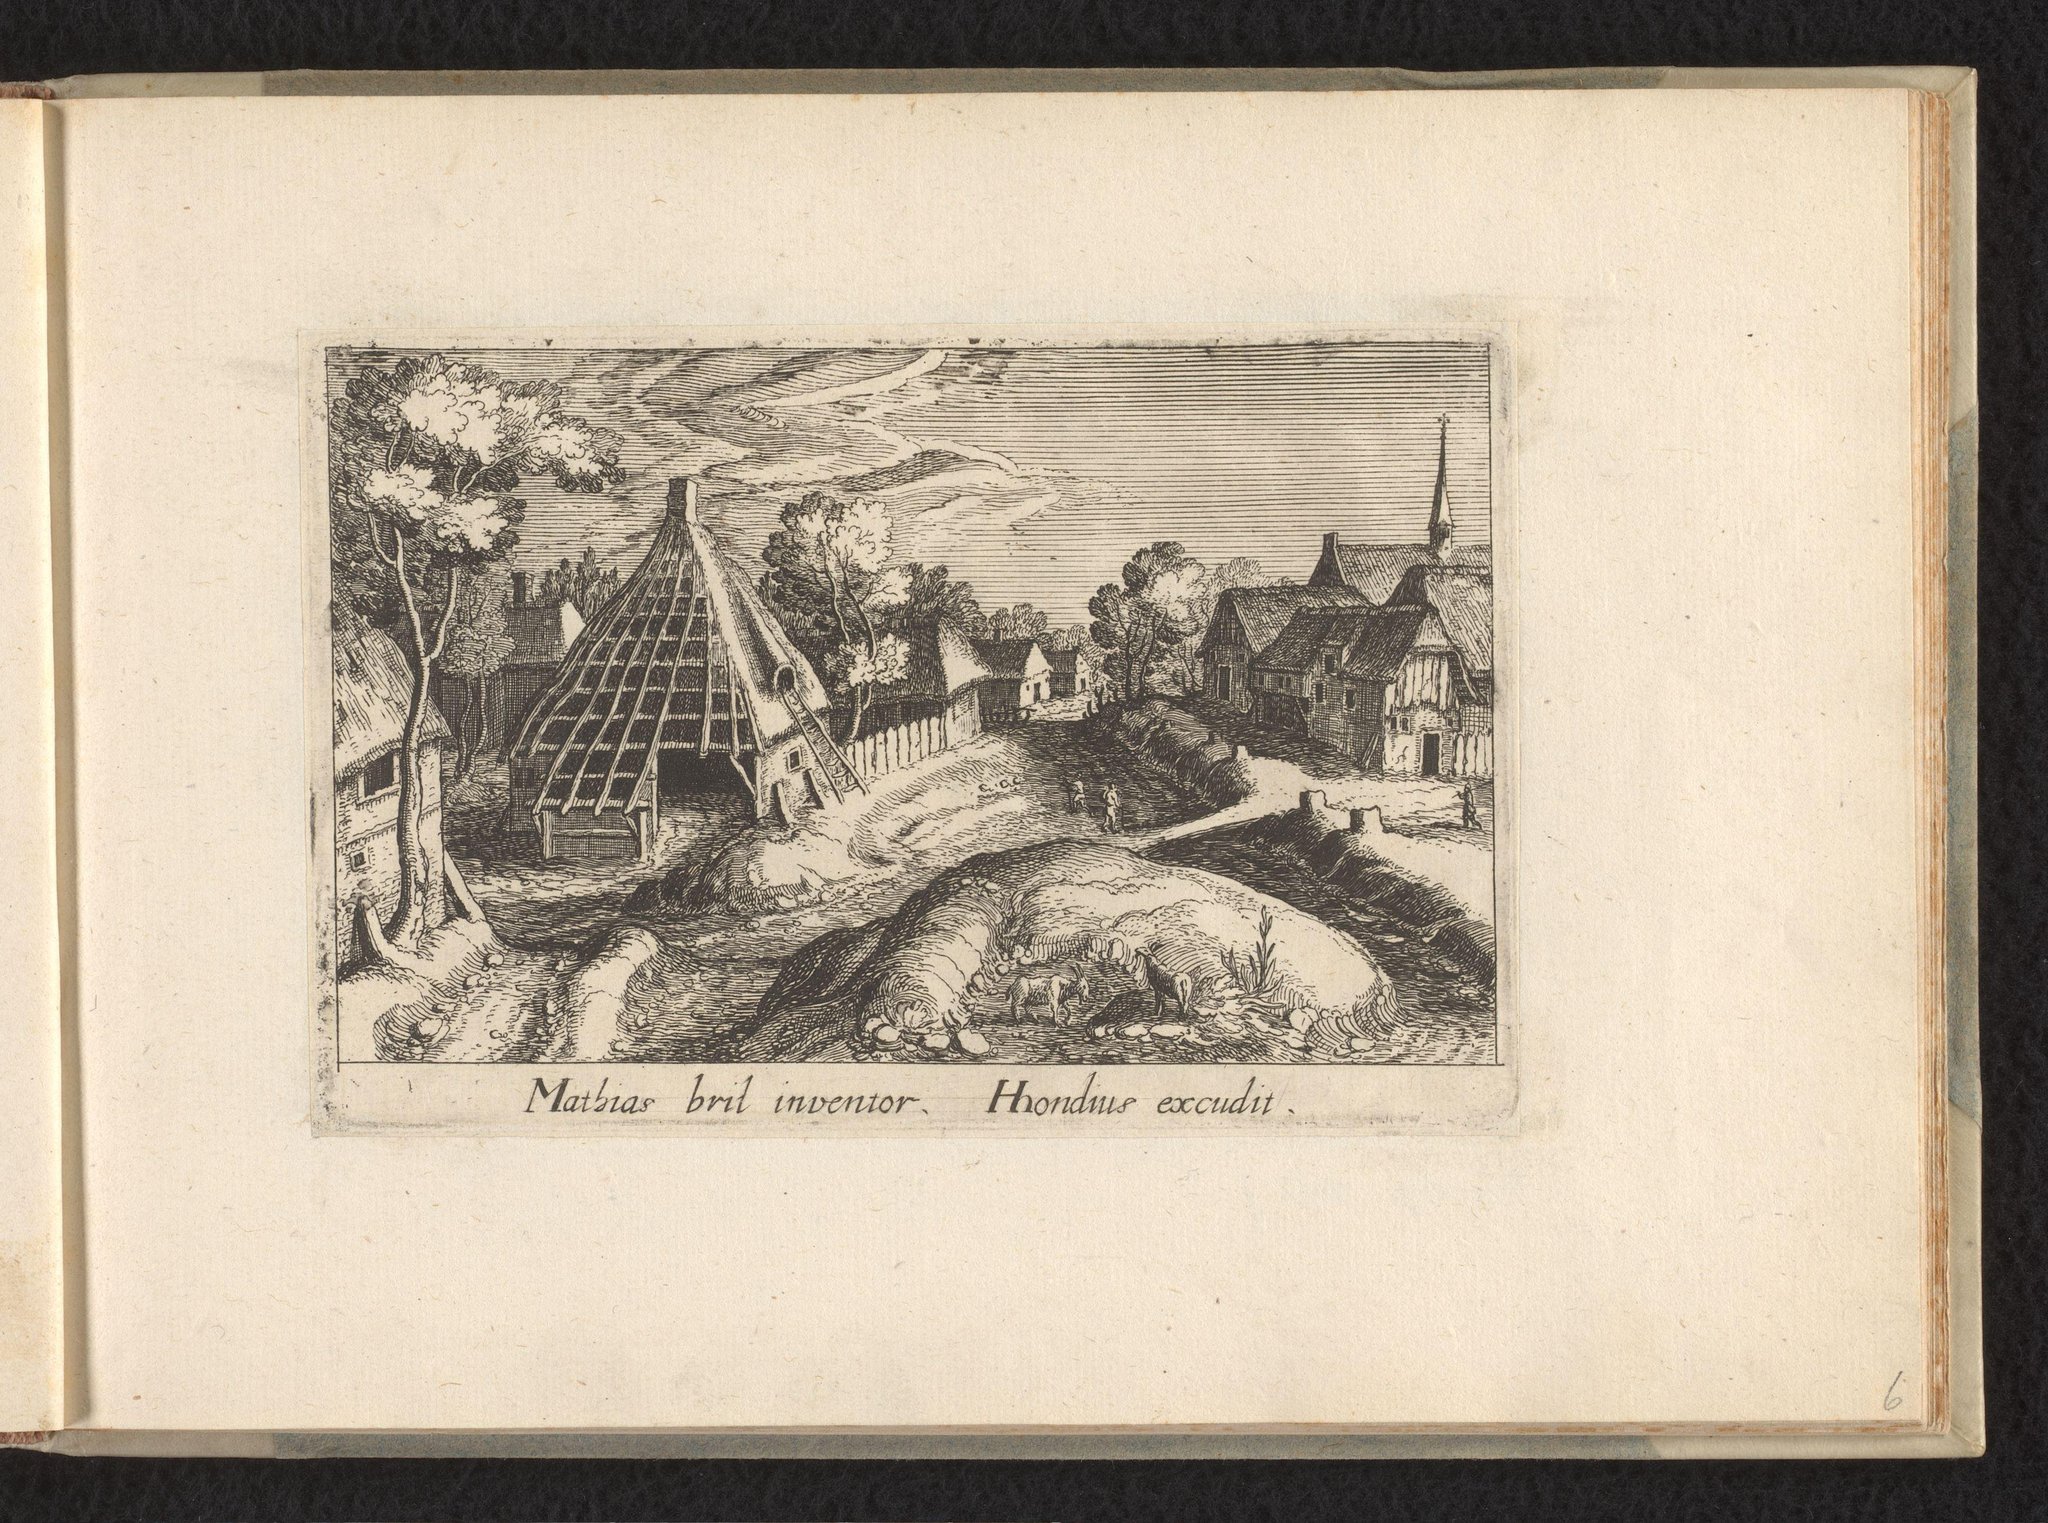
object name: print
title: Topographia Variarum Regionum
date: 1614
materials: paper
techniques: etching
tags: roof-covering, village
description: Middenvoor twee geiten. Rechts een rijtje houten huizen en een kerktoren.